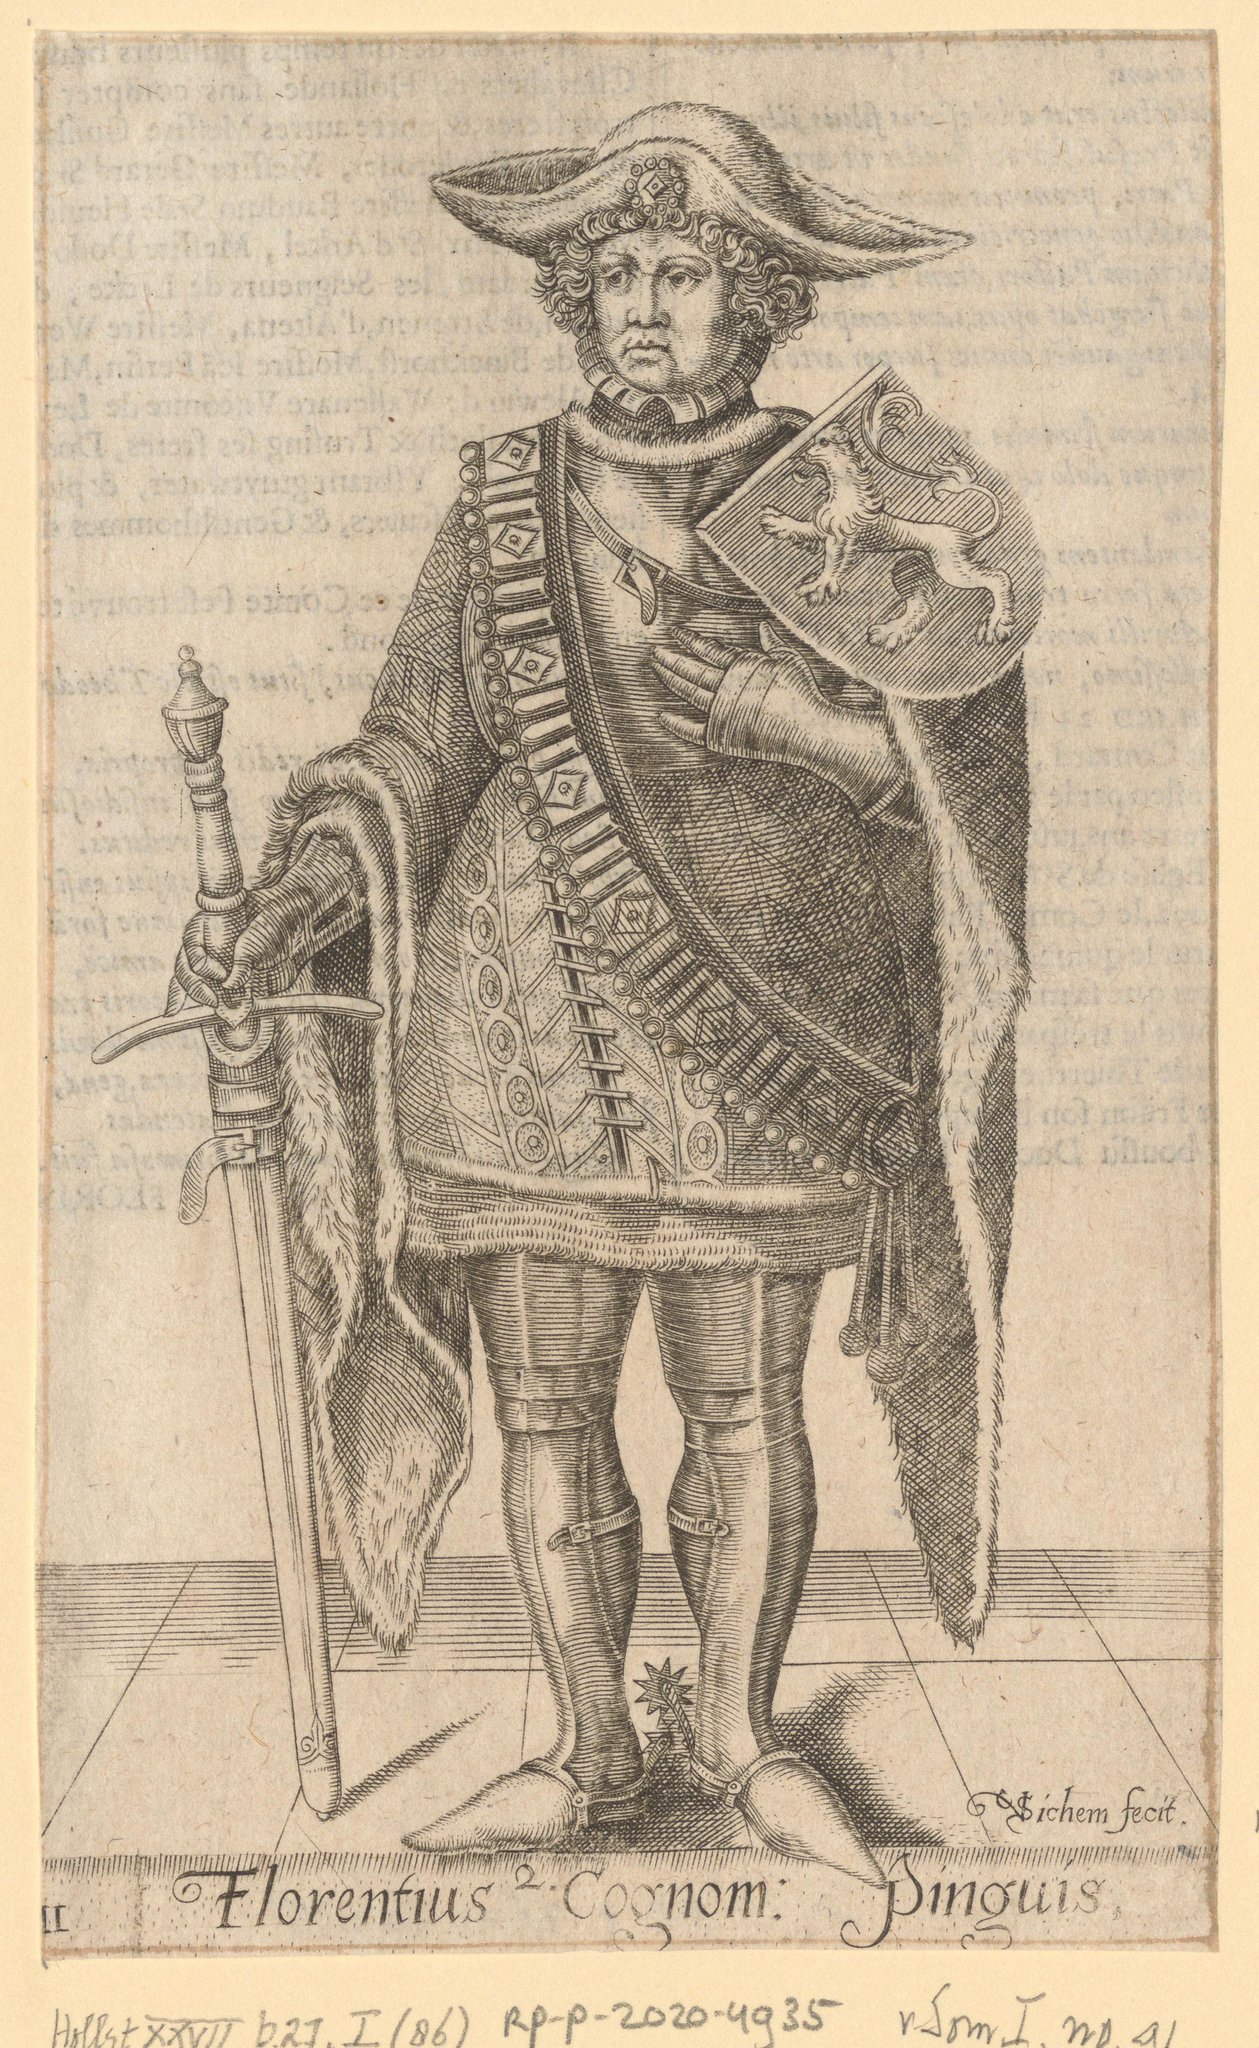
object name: book illustration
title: Portret van Floris II, graaf van Holland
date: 1601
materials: paper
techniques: engraving, letterpress printing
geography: dordrecht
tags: floris ii (count of holland), armour, historical persons, ruler, sovereign, armorial bearing, heraldry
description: Prent uit: Petit, Jean François le. La grande chronique ancienne et moderne, de Hollande, Zelande, West-Frise (...). Dordrecht: Jacob Canin, 1601.